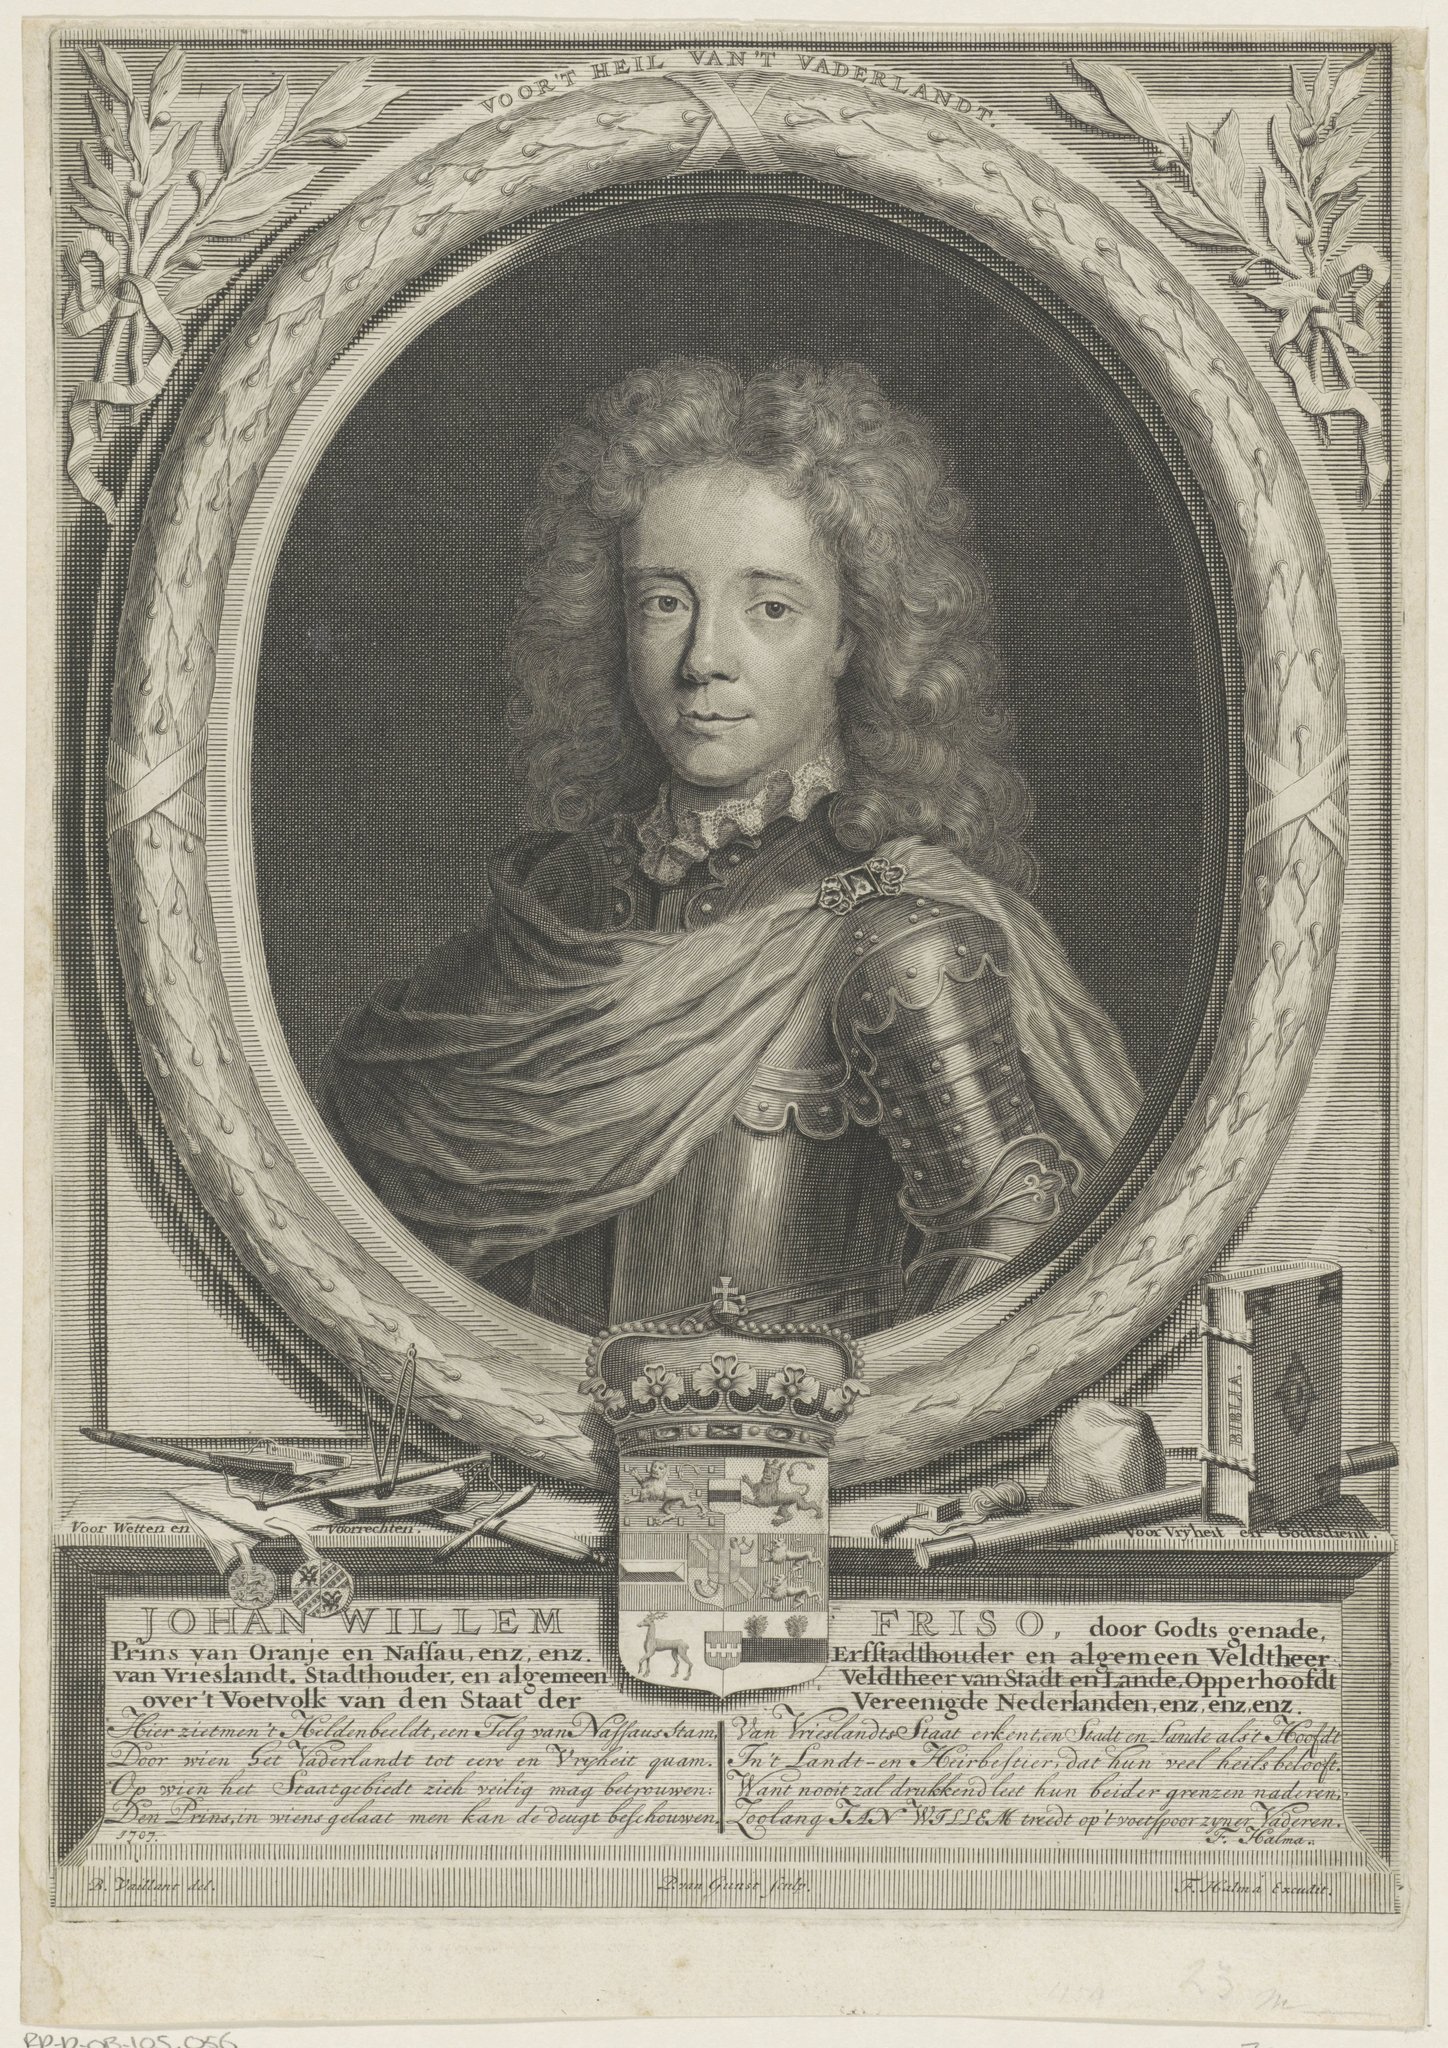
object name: print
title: Portret van Johan Willem Friso, prins van Oranje-Nassau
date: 1707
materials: paper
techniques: engraving, etching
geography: northern netherlands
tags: johan willem friso (prins van oranje-nassau), historical persons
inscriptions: date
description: Portret van Johan Willem Friso in een geornamenteerd ovaal van eikenbladen met randschrift. Rondom ligt een aantal allegorische objecten. Midden onder zijn wapen met een kroon. Op een voetstuk zijn naam, zijn titels en twee kolommen met elk vier regels Nederlandse tekst.